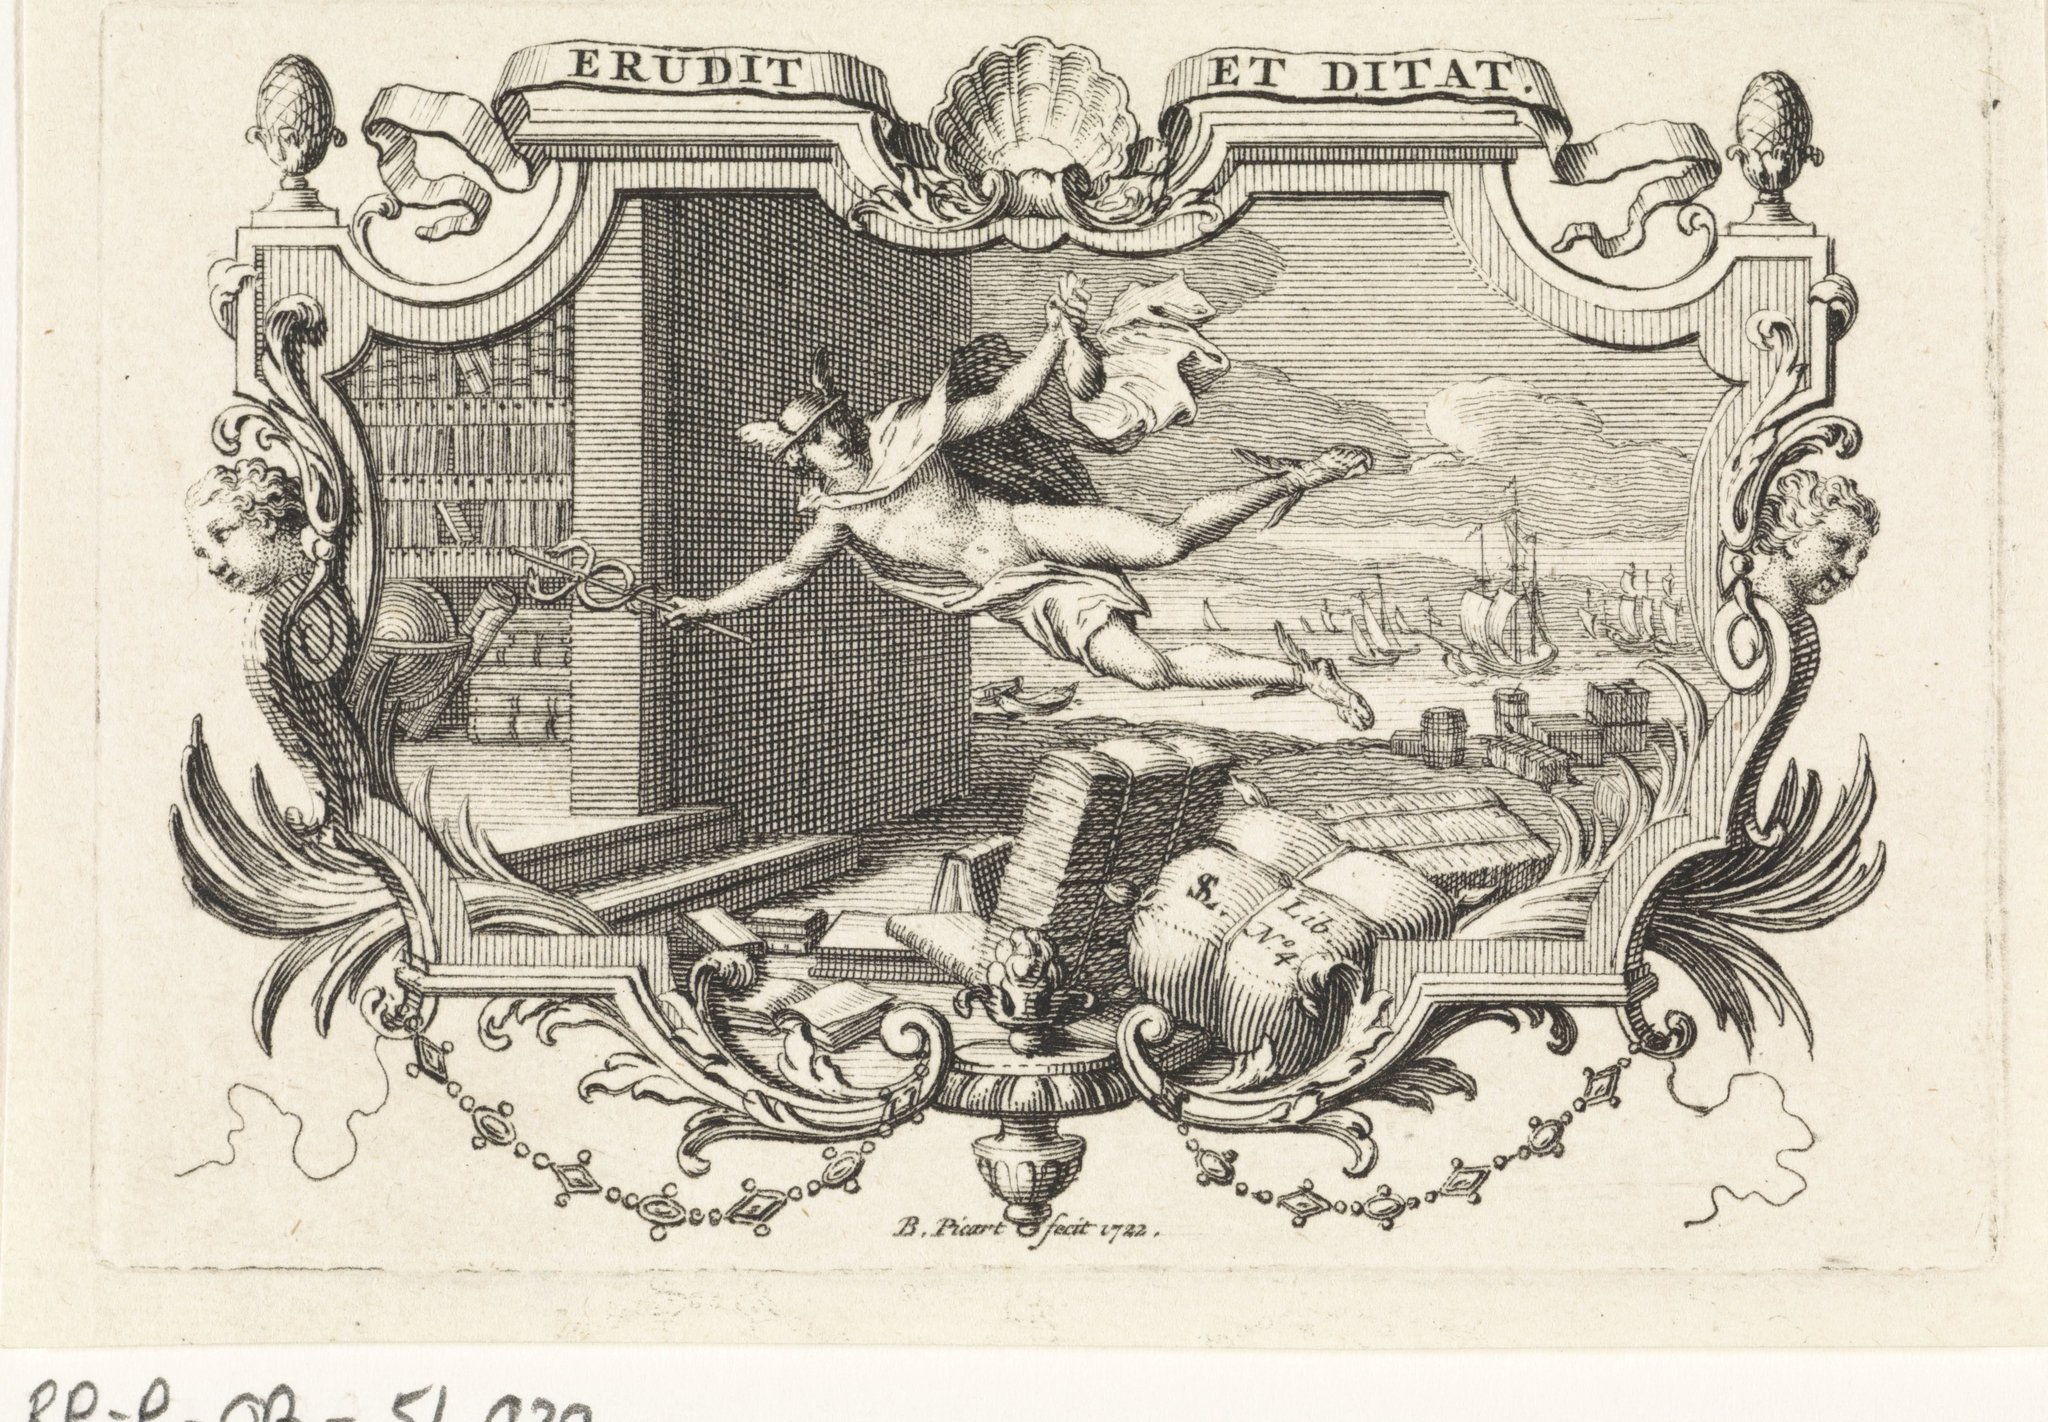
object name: print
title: Mercurius als god van de geleerdheid en handel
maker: bernard picart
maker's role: draughtsman, print maker, publisher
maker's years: 1673-1733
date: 1722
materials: paper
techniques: engraving, etching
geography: amsterdam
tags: scrollwork, strapwork ~ ornament, specific aspects, allegorical aspects of mercury; mercury as patron, foliage, tendrils, branches ~ ornament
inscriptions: collector's mark: Lugt 2228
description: De vliegende Mercurius, met een zak geld in de hand, als beschermer van de geleerdheid en de handel. Links een studeerkamer en rechts schepen op zee. Boven de prent het devies: Erudit et Ditat (Leer en verrijk).